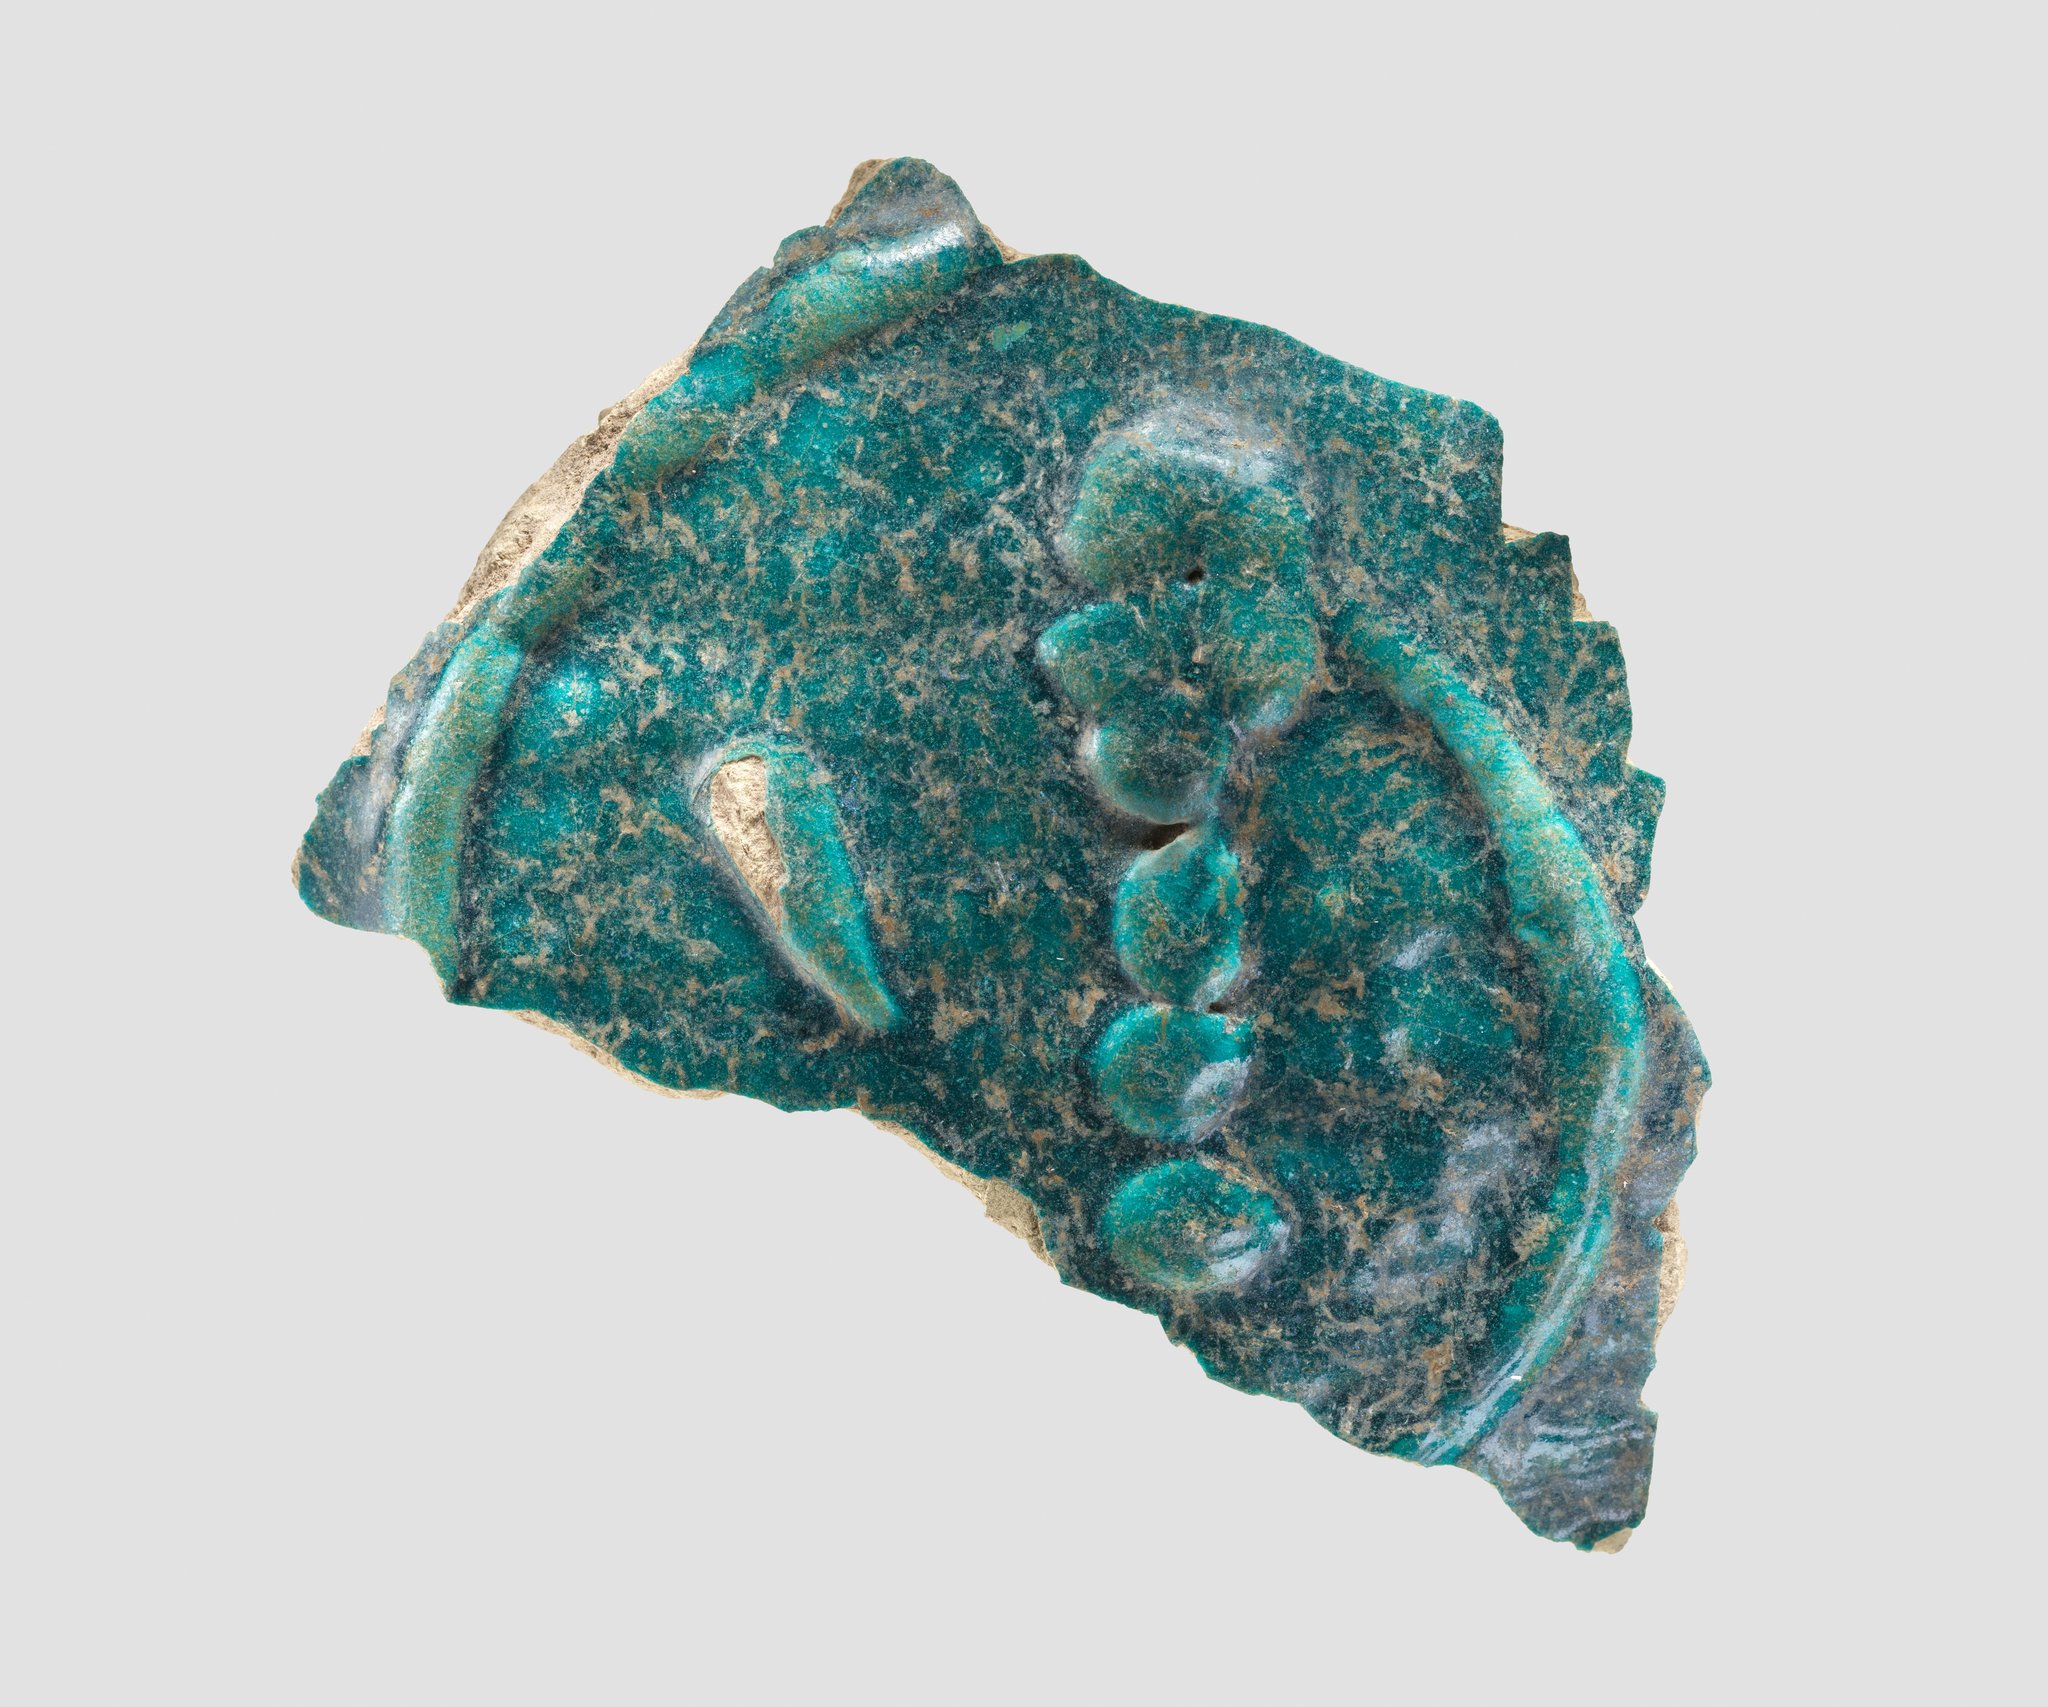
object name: jar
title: Jar sherd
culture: sasanian or islamic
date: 601-800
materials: ceramic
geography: mesopotamia